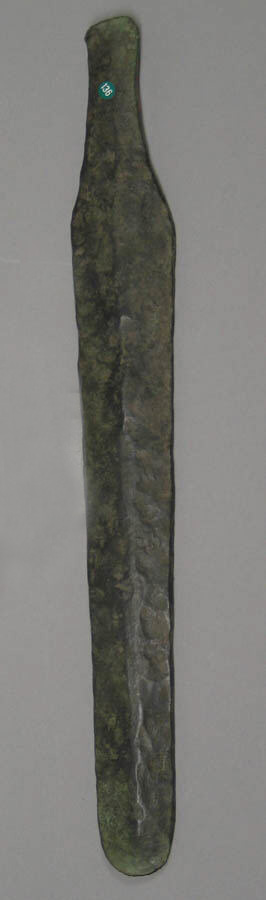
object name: sword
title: Antennae Sword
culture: indian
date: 1500-500 BCE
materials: copper